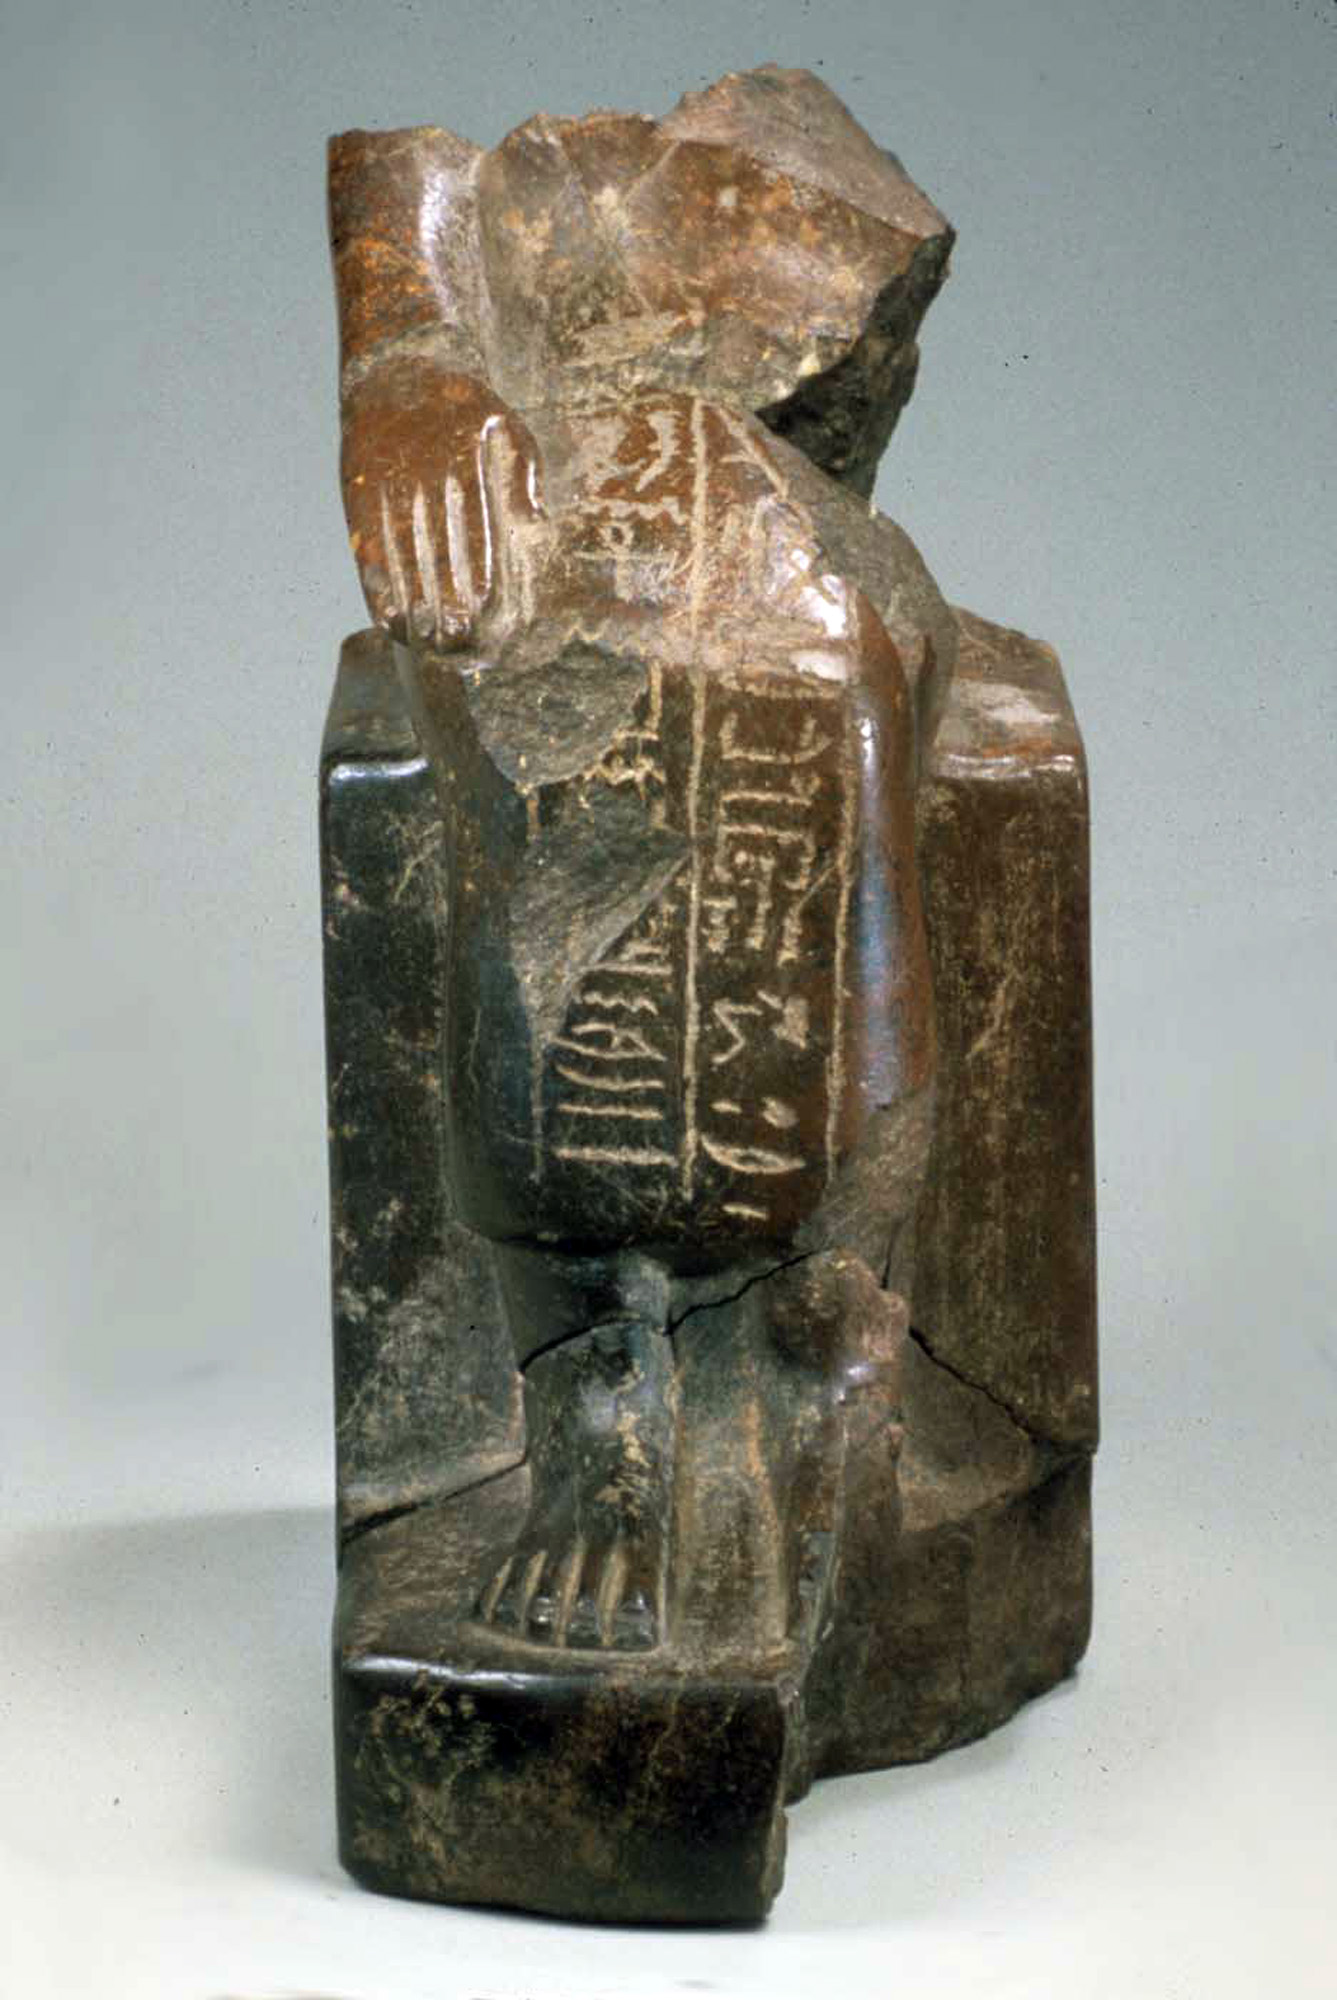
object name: statue, anu lower half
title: Lower half of the figure of the dignitary Anu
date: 1802-1640 BCE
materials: stone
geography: egypt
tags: hieroglyphs